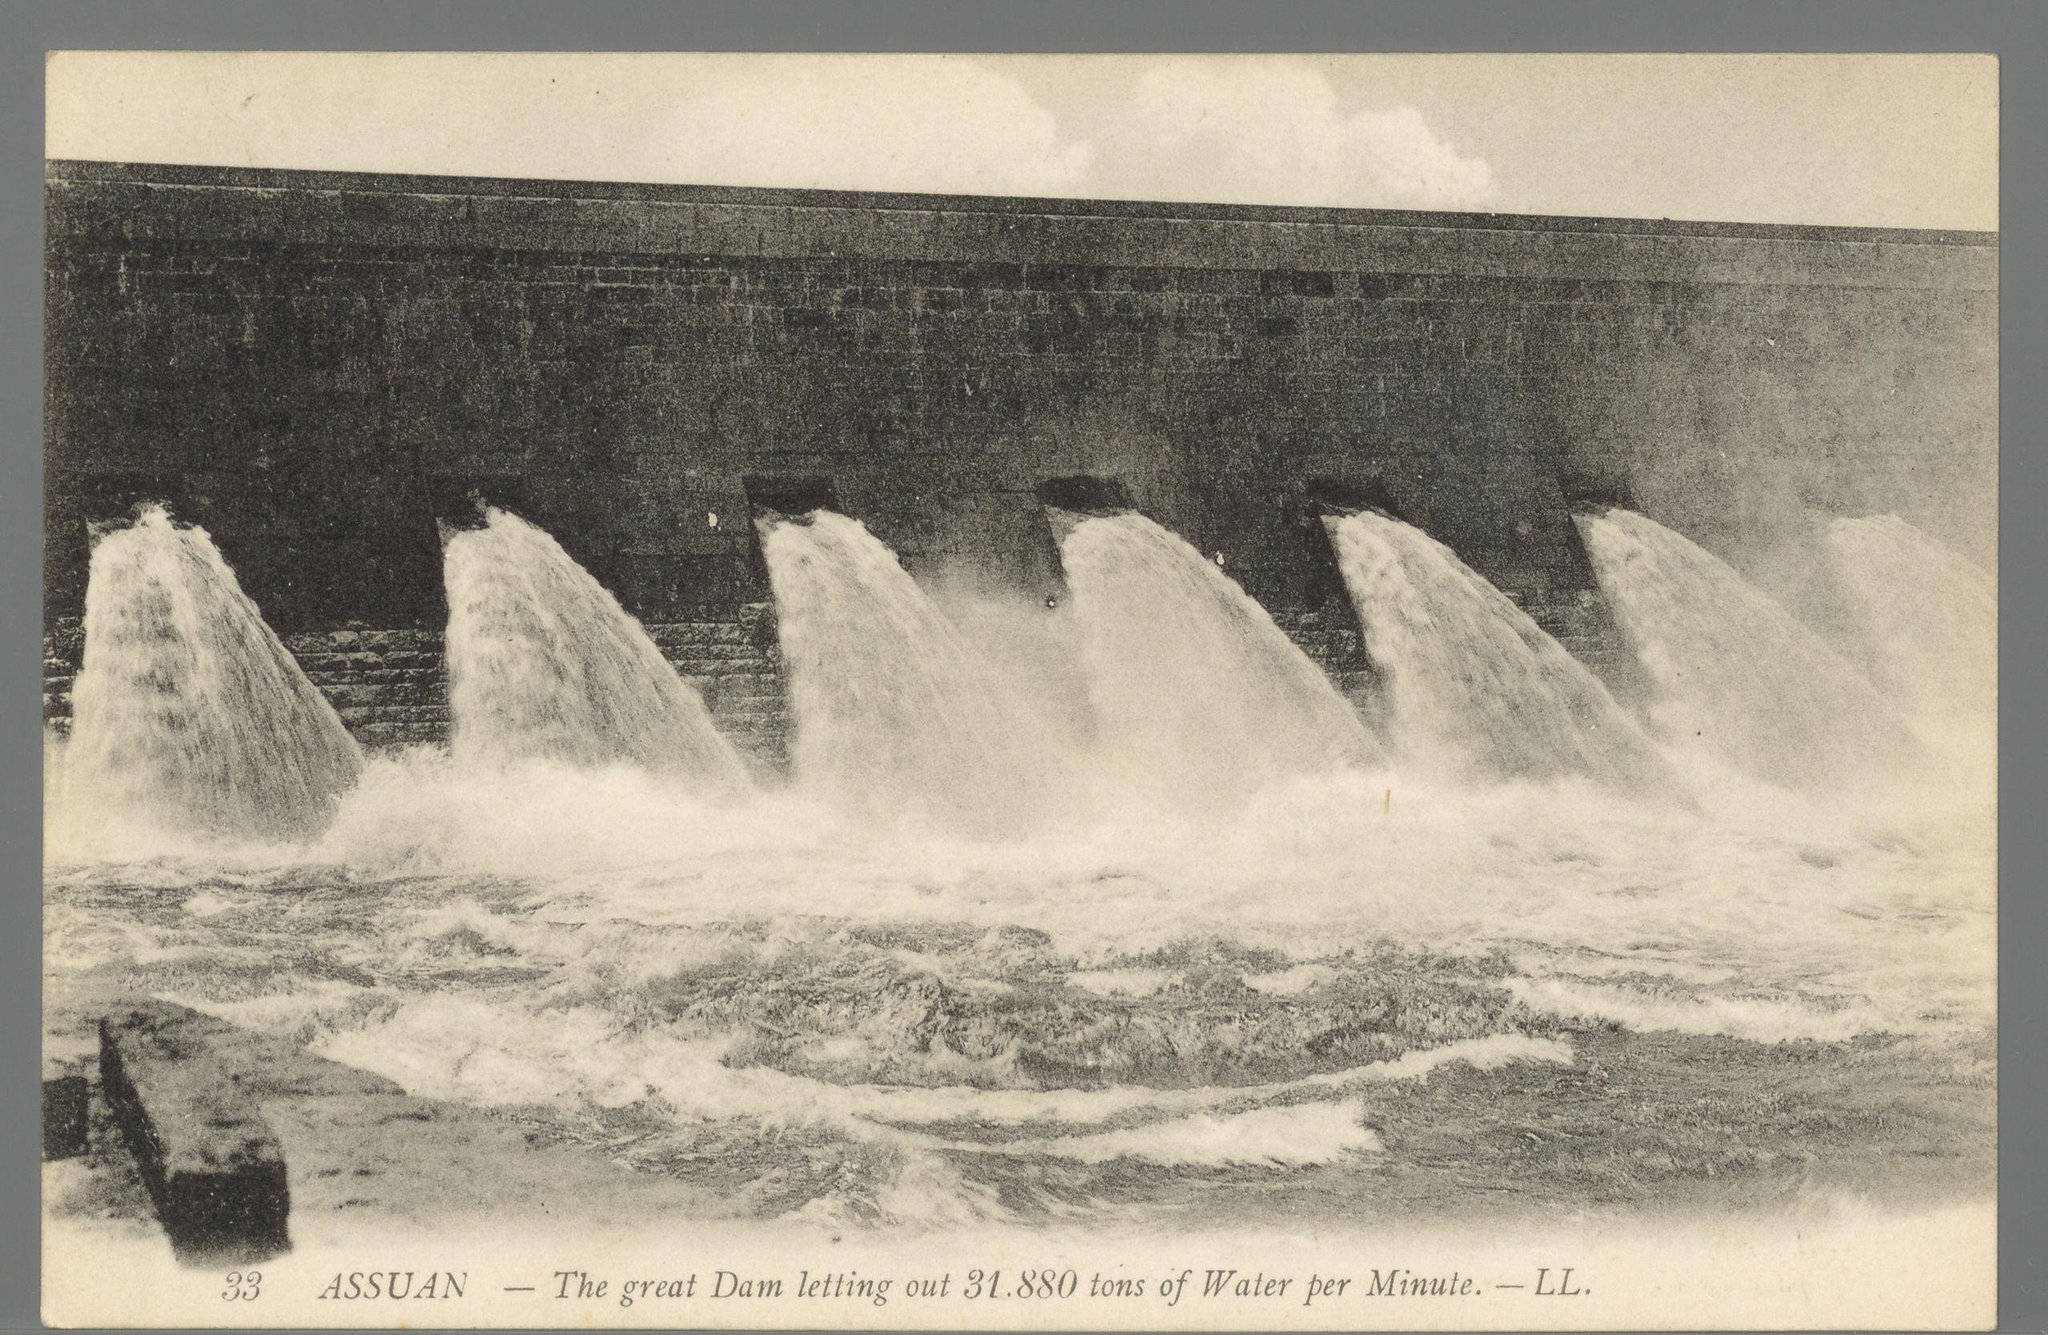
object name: photomechanical print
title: Assuan - The great Dam letting out 31.880 tons of water per minute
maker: Anonymous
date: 1907-1930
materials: cardboard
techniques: photograph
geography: aswan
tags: river, dam (in canal)